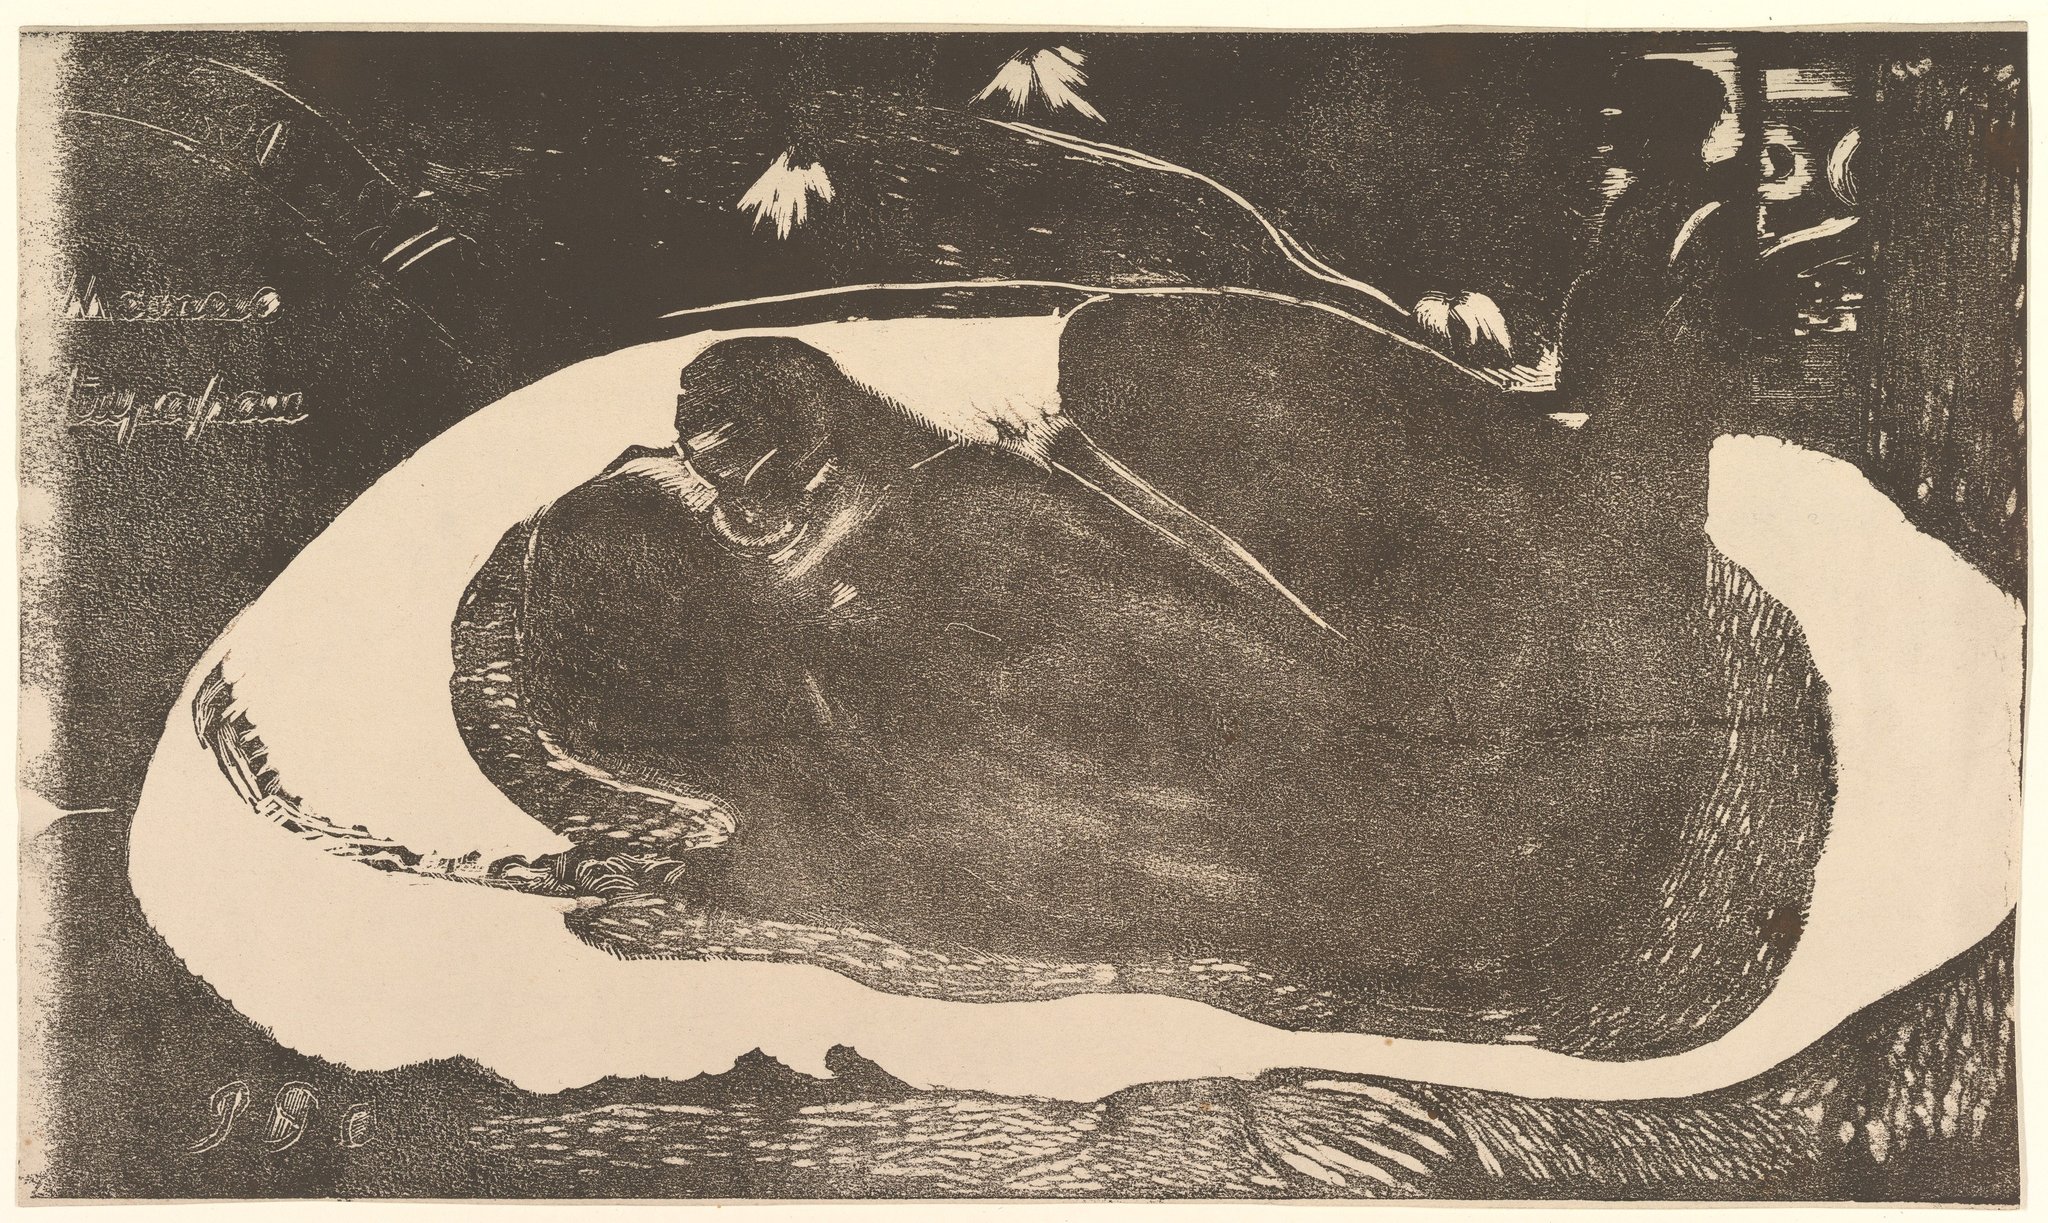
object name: print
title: Spirit of the Dead Watching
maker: paul gauguin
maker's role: artist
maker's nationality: french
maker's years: 1848-1903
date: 1893-1894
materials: paper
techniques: printing, woodcut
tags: death